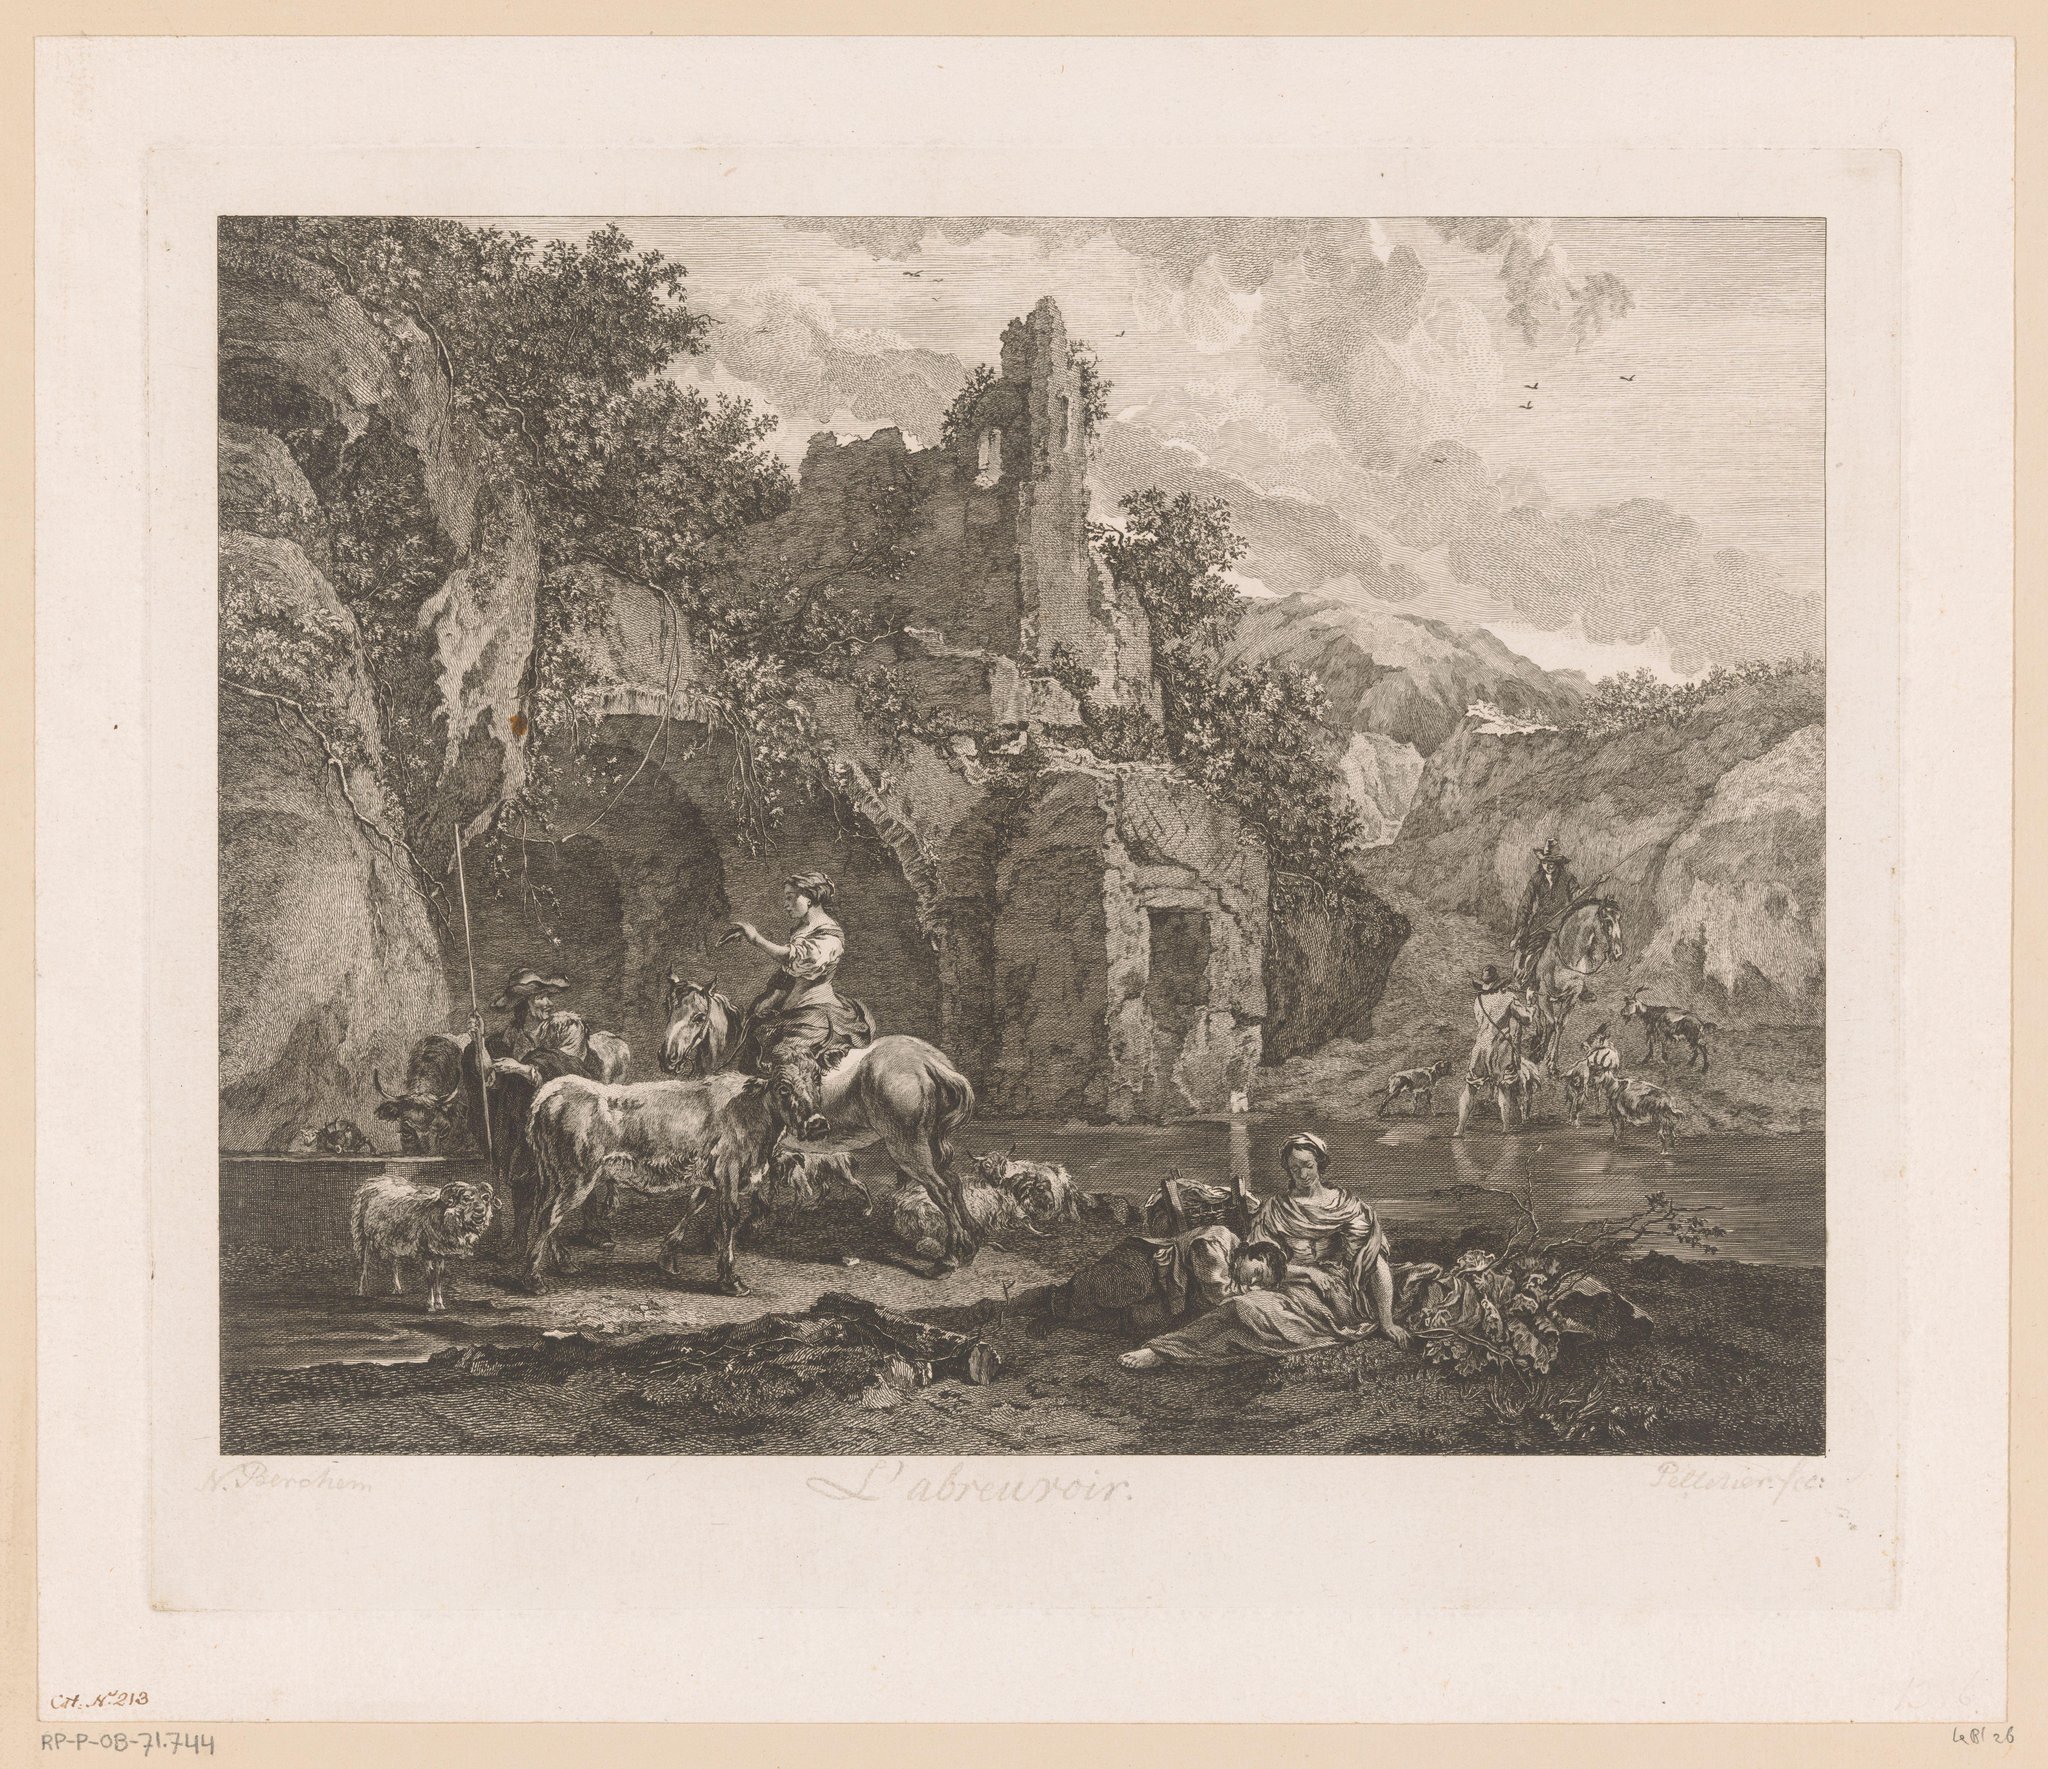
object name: print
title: L'Abreuvoir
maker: jean pelletier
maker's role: print maker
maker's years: 1736-1780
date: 1746-1780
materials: paper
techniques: engraving, etching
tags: landscape with ruins, giving water, feeding (cattle), pastorals, arcadian scenes, herd, flock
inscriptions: collector's mark: Lugt 240